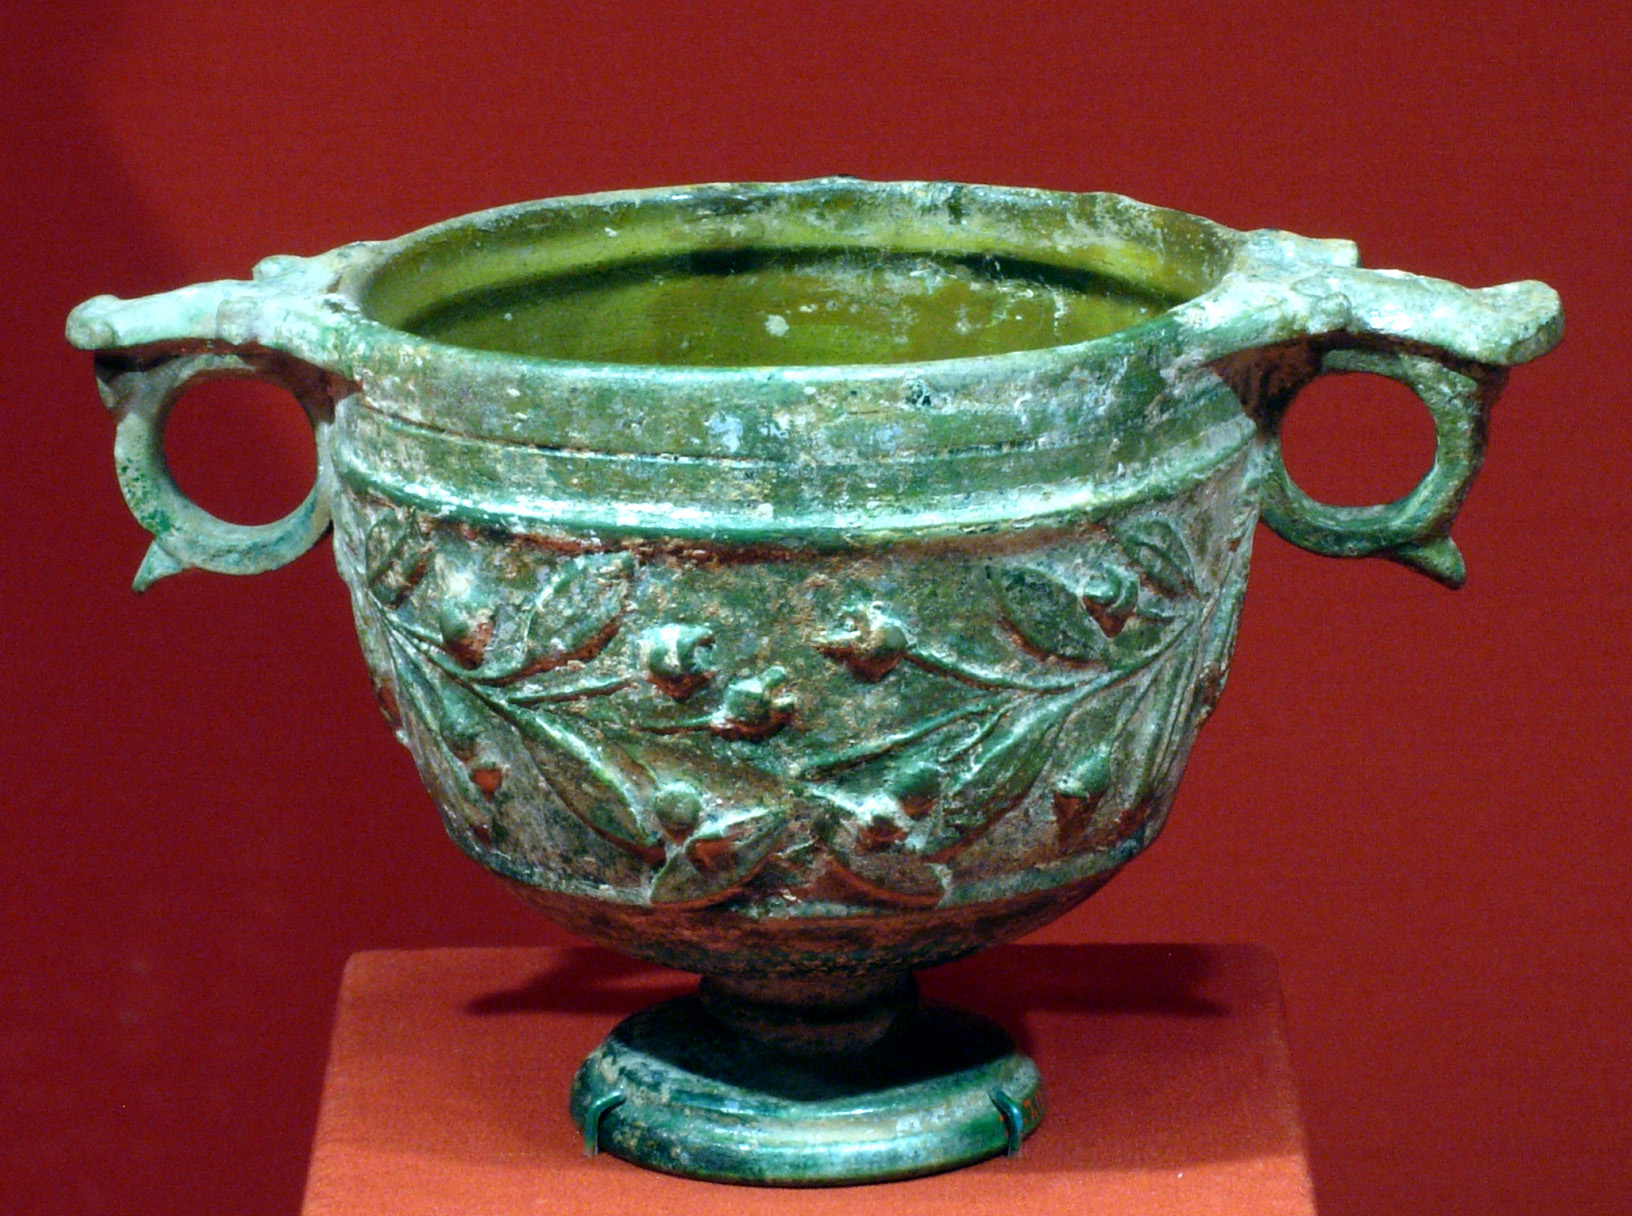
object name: cup skyphos, laurel spray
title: Skyphos (footed wine-cup) with laurel sprays on the body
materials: terracotta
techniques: glazing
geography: egypt